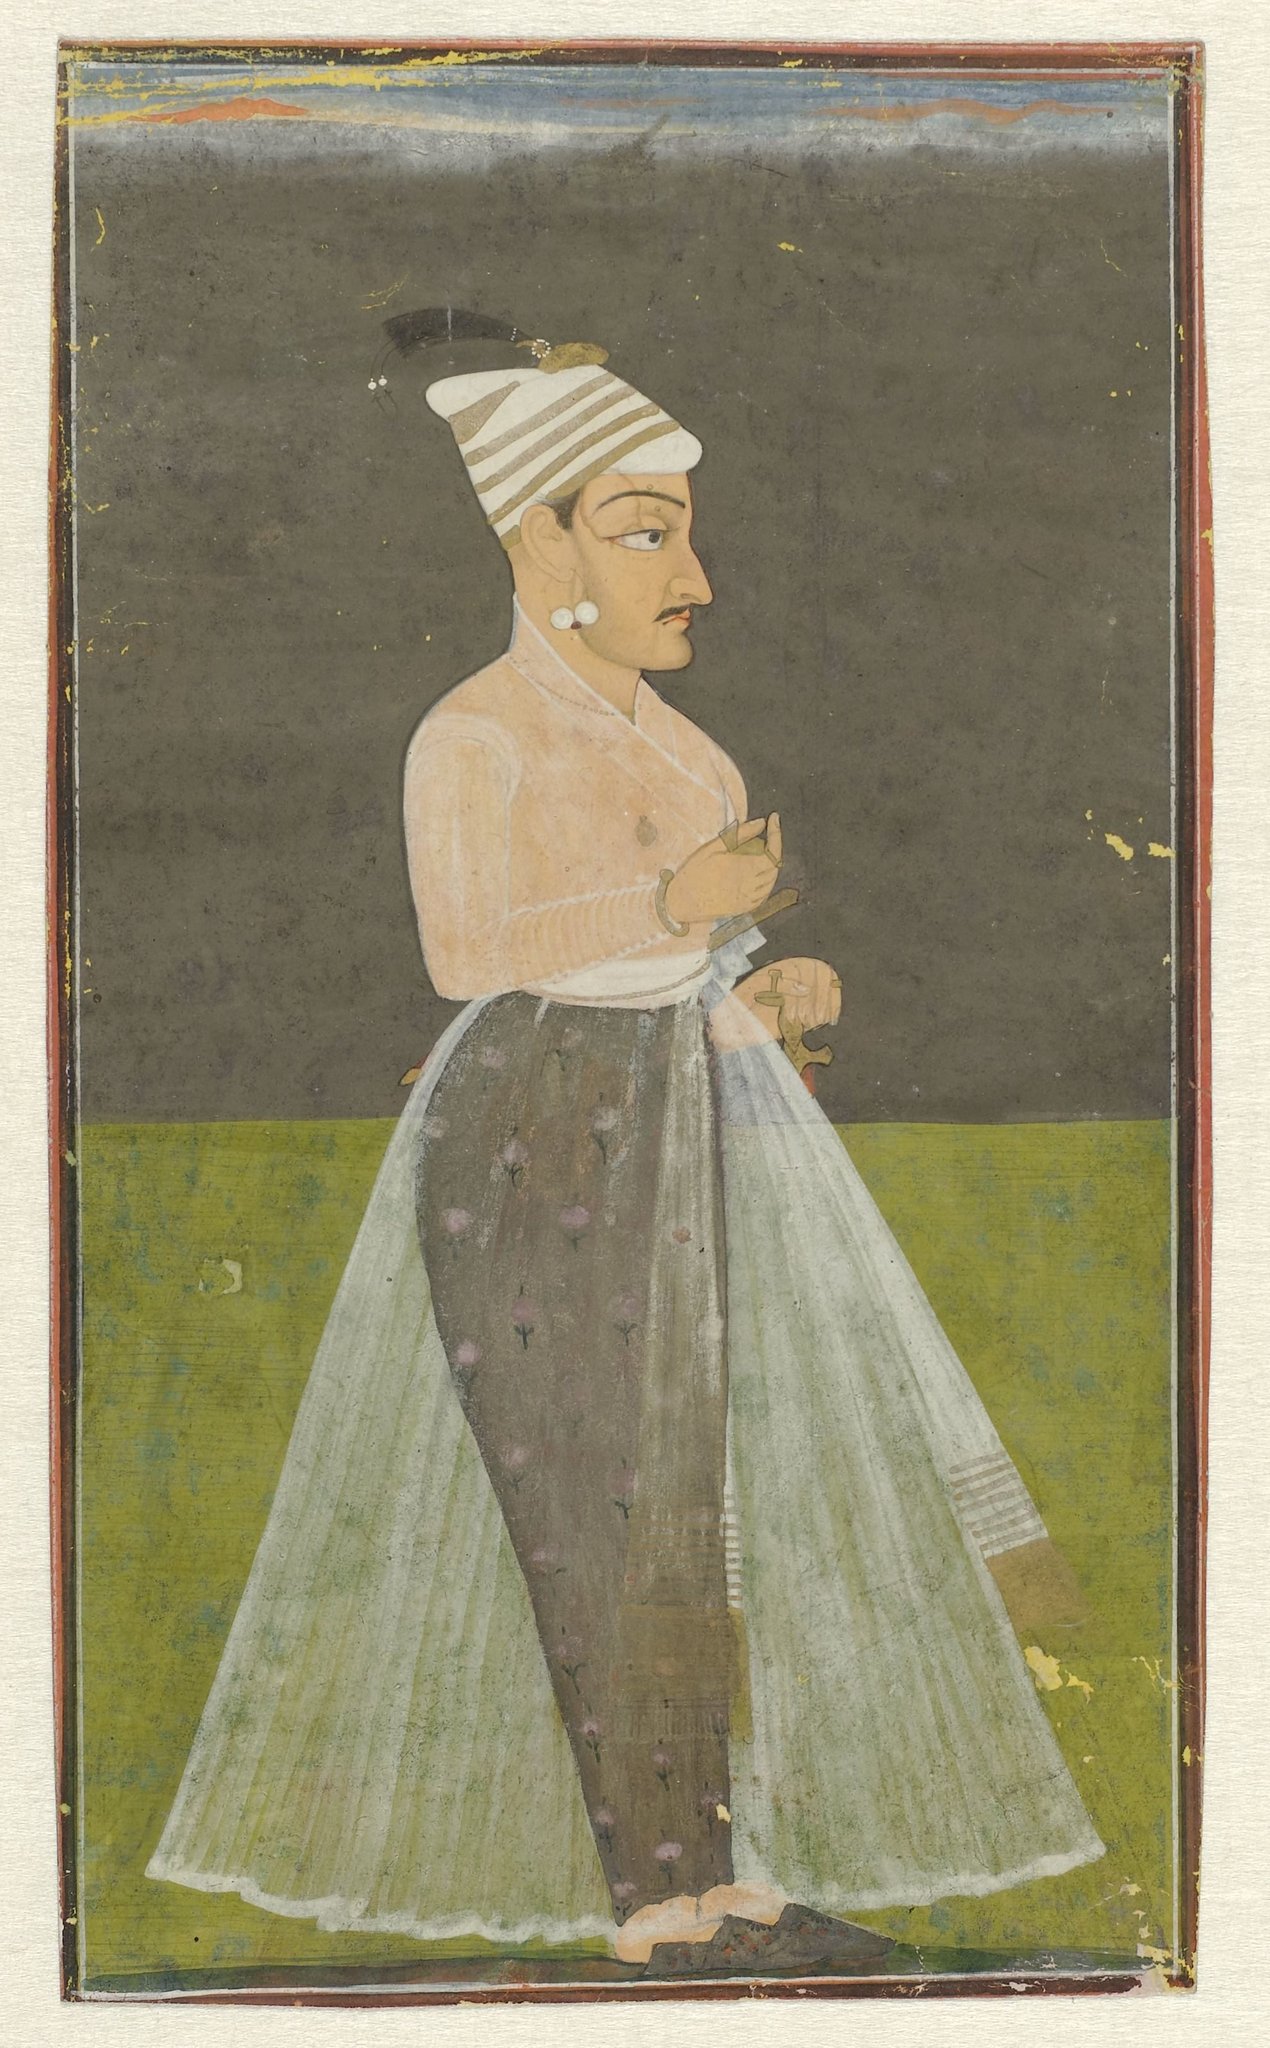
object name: indian miniature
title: Portret van Daya Datta, Raja van Nurpur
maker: Anonymous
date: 1720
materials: paper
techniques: brush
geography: nurpur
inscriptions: inscription: ‘.’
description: Tegen een achtergrond van groen en donkergrijs staat een vorstelijk personage met profiel naar rechts; de linkerhand rust op de heft van zijn zwaard, in zijn rechterhand houdt hij iets ondefinieerbaars geklemd. De voorstelling is omlijst door een paar smalle gekleurde kaderlijntjes in zwart, wit en rood.